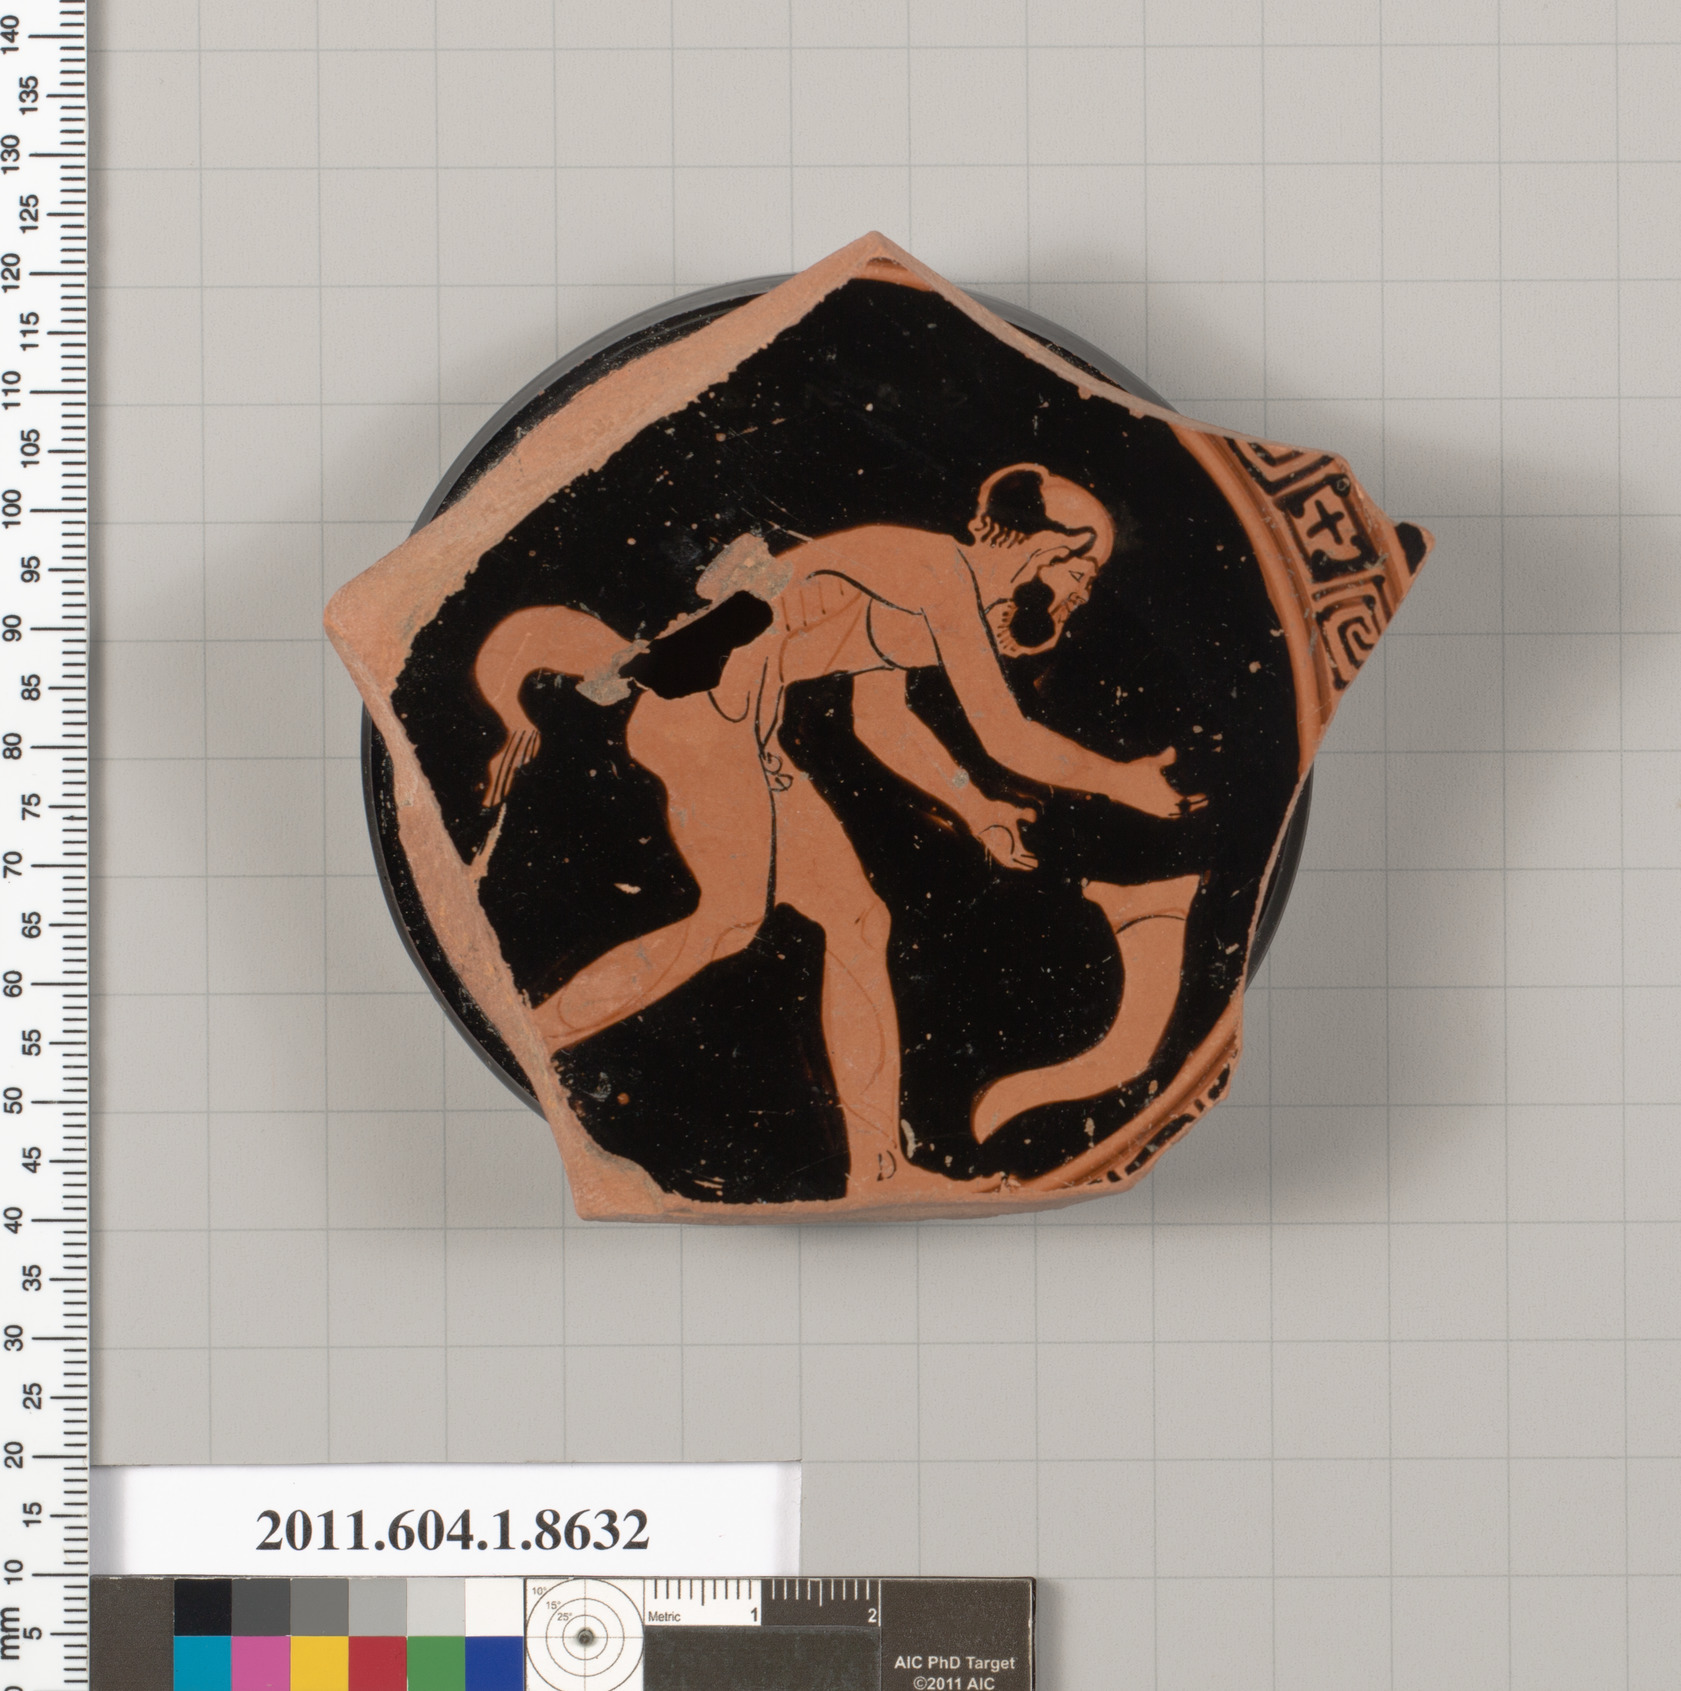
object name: kylix fragment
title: Terracotta fragment of a stemless kylix (drinking cup)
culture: greek, attic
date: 460-450 BCE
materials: terracotta